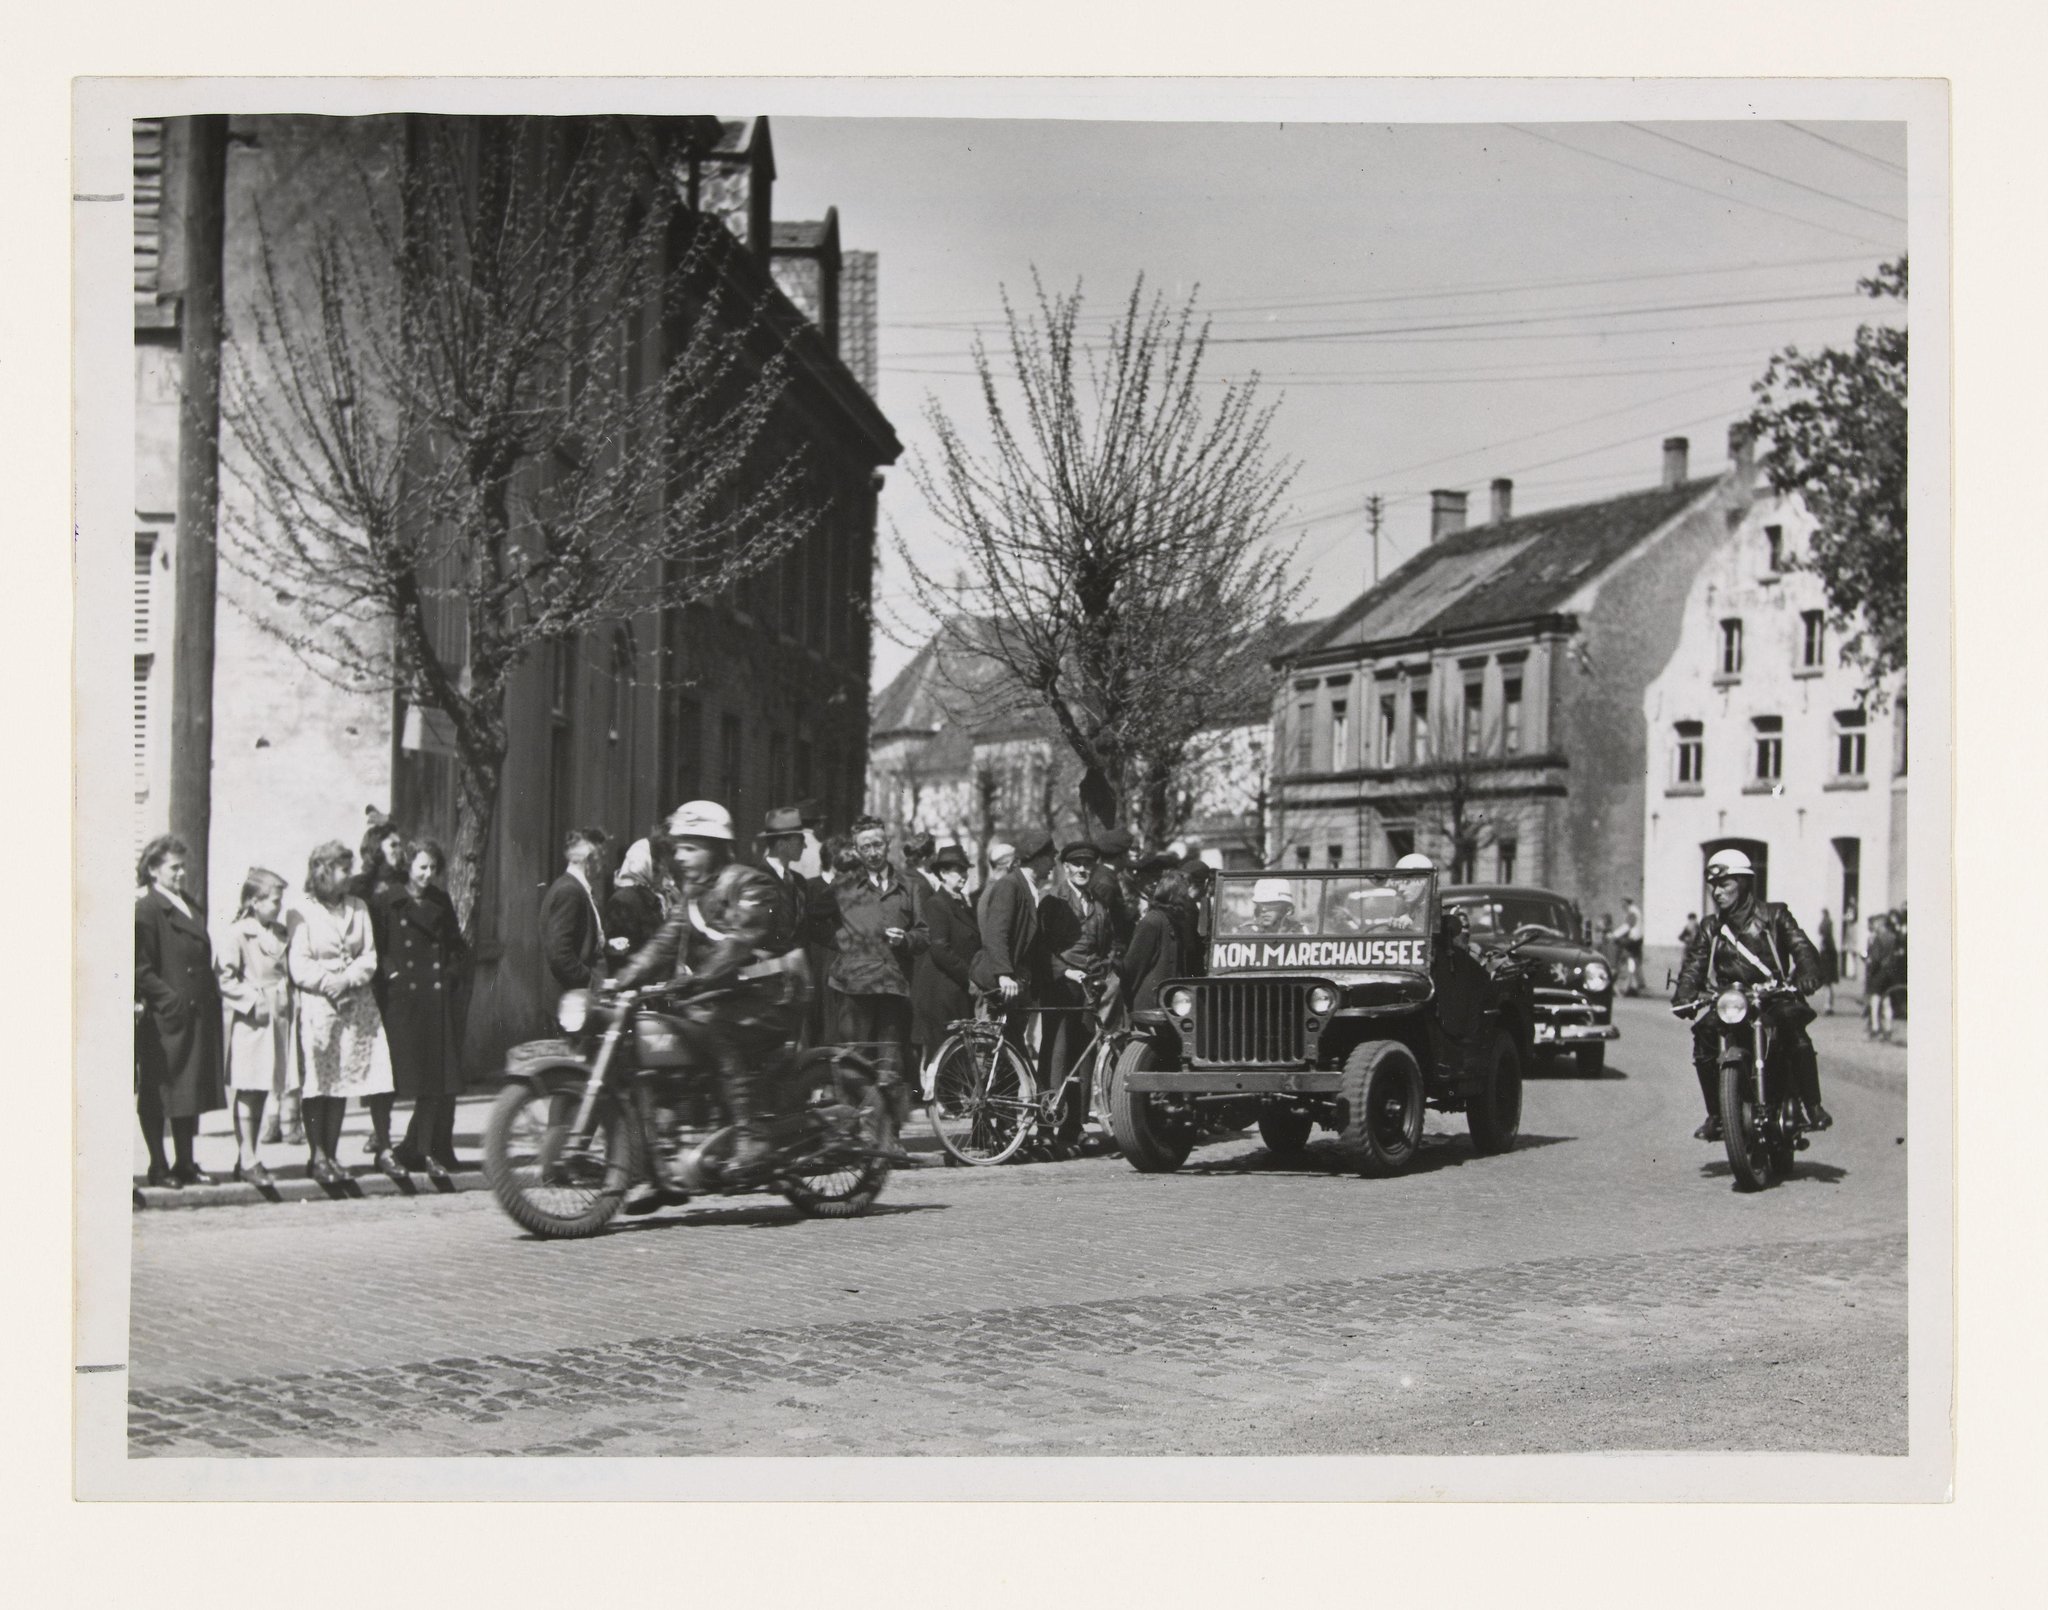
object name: documentary photograph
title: Marechaussees trekken Elten binnen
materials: photographic support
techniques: photography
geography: elten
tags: elten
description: Even na 12:00 uur trekken de marechaussees op motoren en jeeps Elten binnen. Zij vergezellen de intrede van de nieuwe landdrost. Aan de straatkant slaan een aantal belangstellenden de intrede van de 'bezetters' gade.